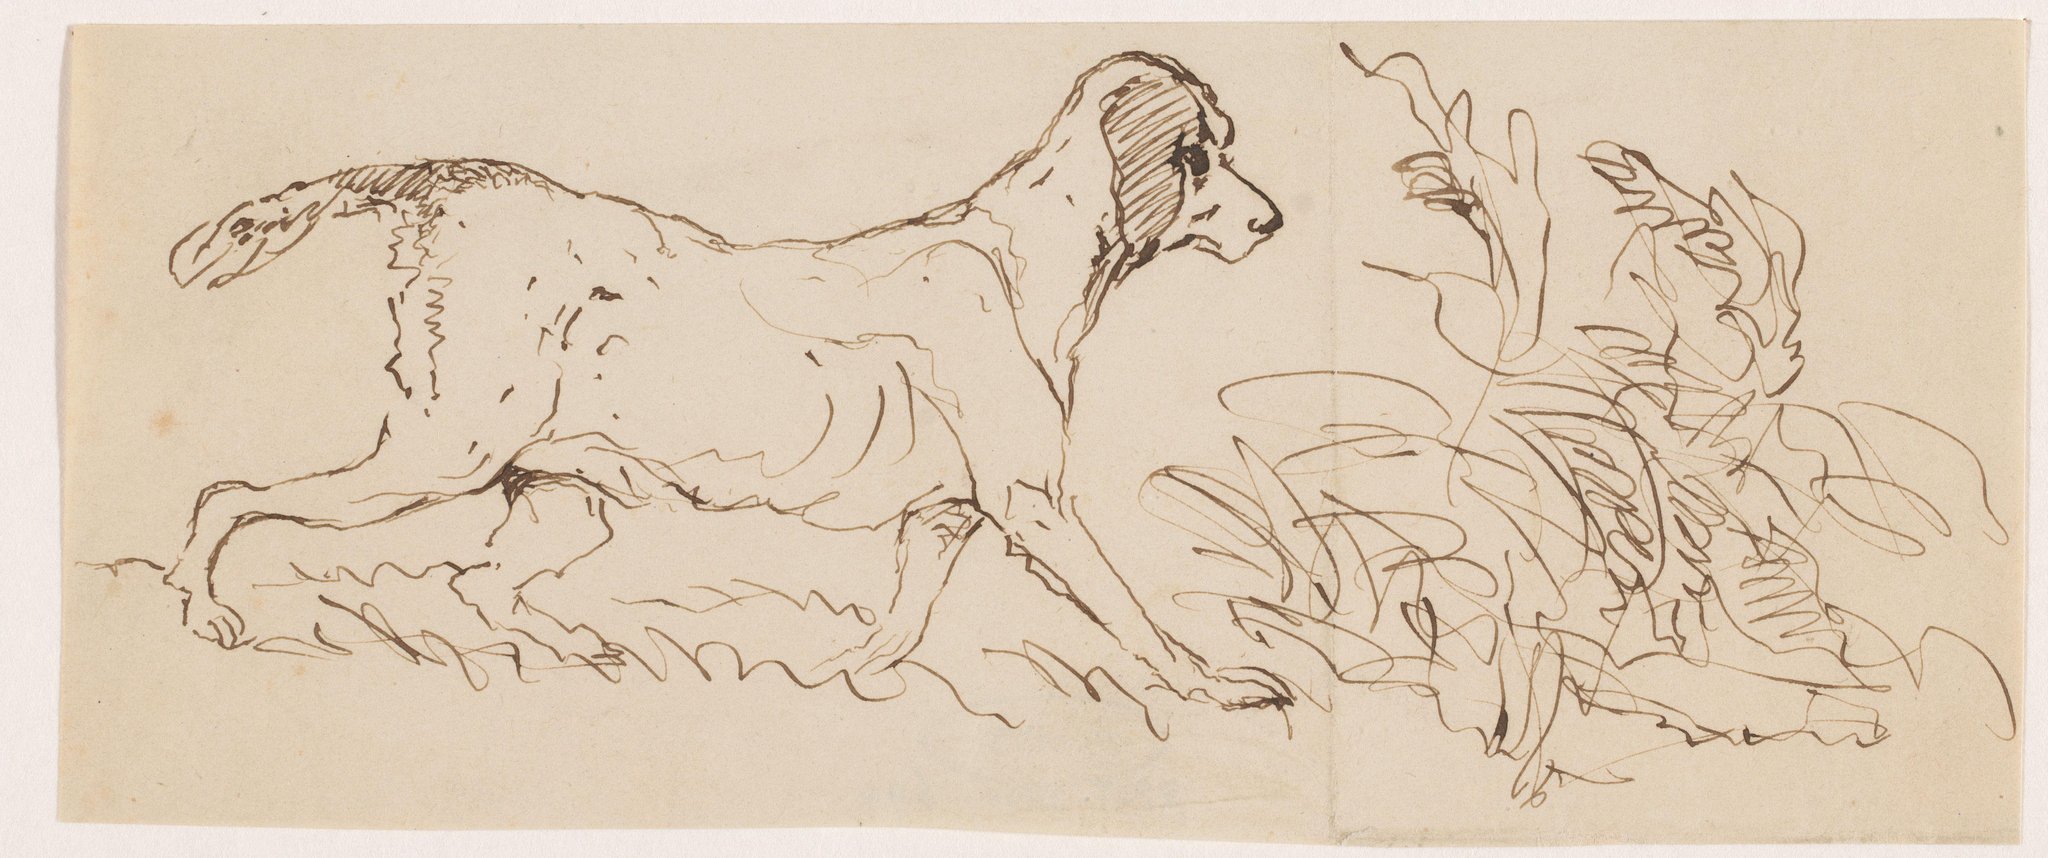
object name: drawing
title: Jachthond in het veld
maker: johannes tavenraat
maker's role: draughtsman, painter, print maker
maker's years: 1809-1881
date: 1840-1880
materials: ink, paper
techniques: pen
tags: hunting dogs, dog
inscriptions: collector's mark: Lugt 2228